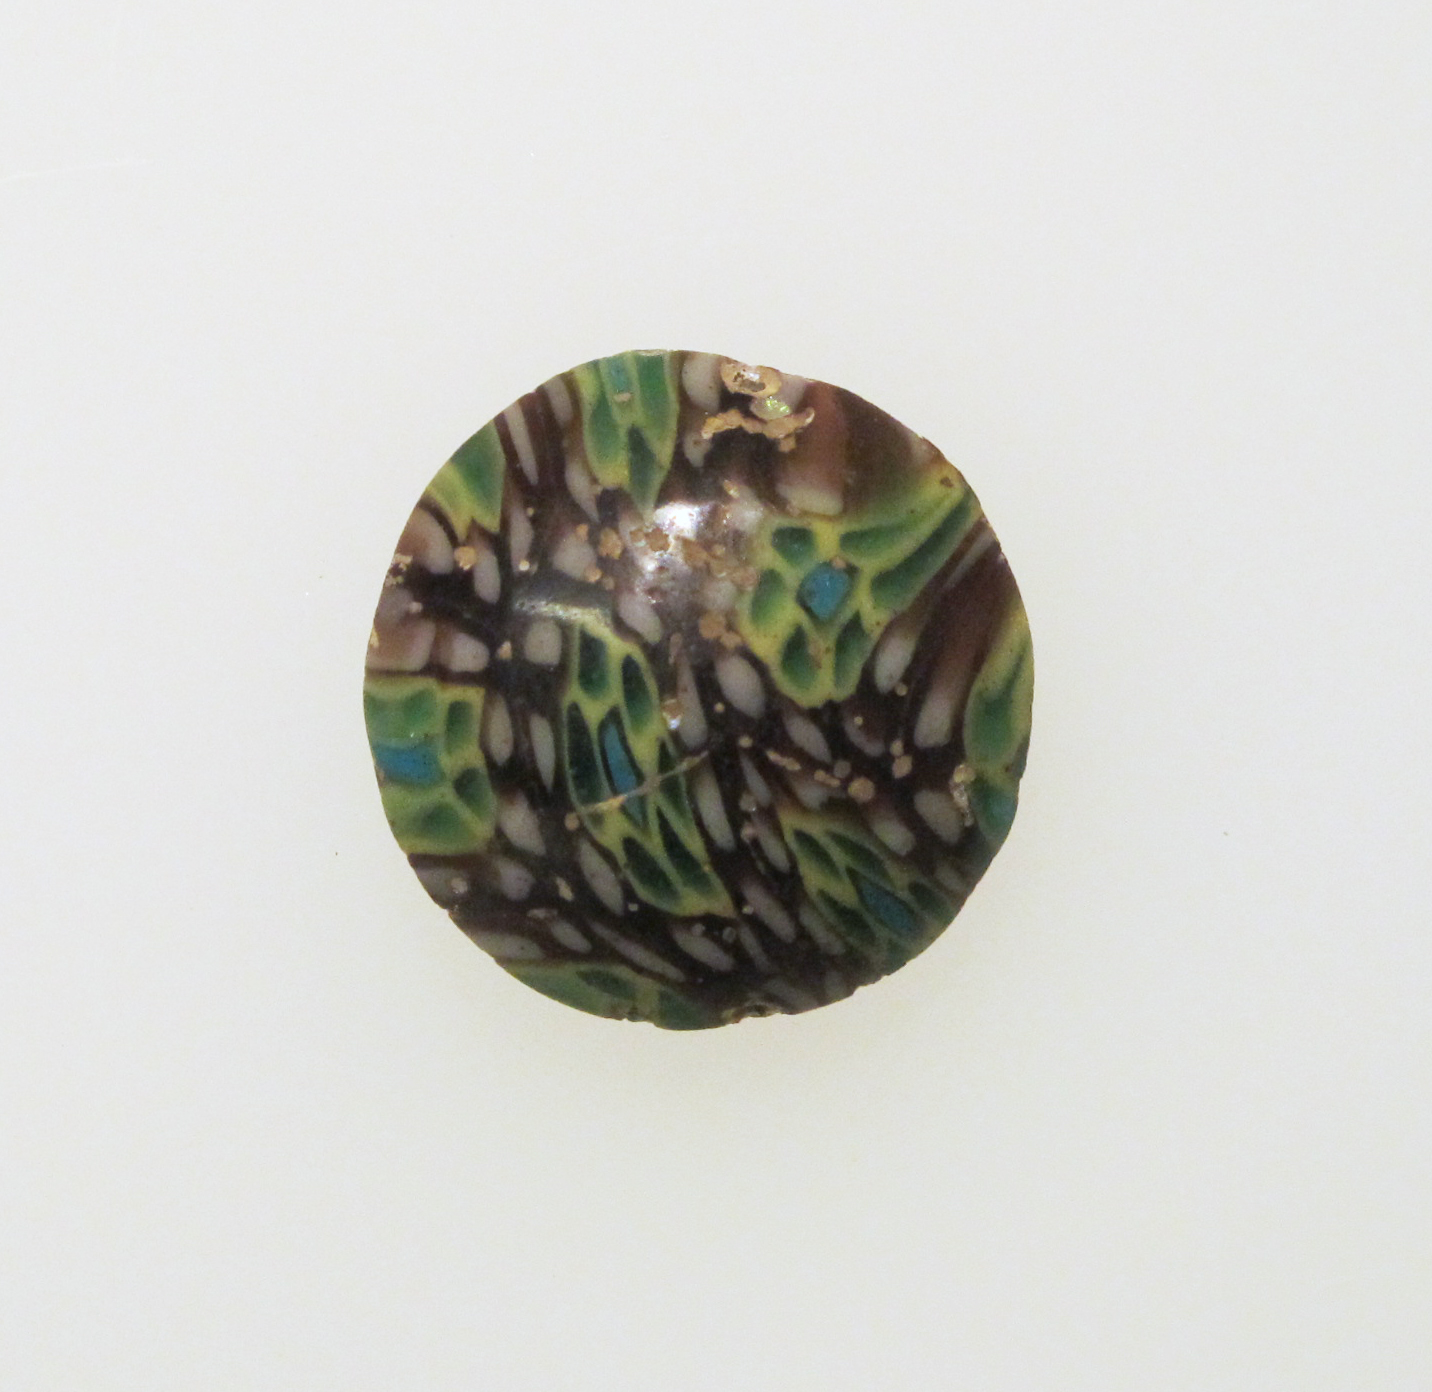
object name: pinhead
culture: roman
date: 670 BCE-330 CE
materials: glass